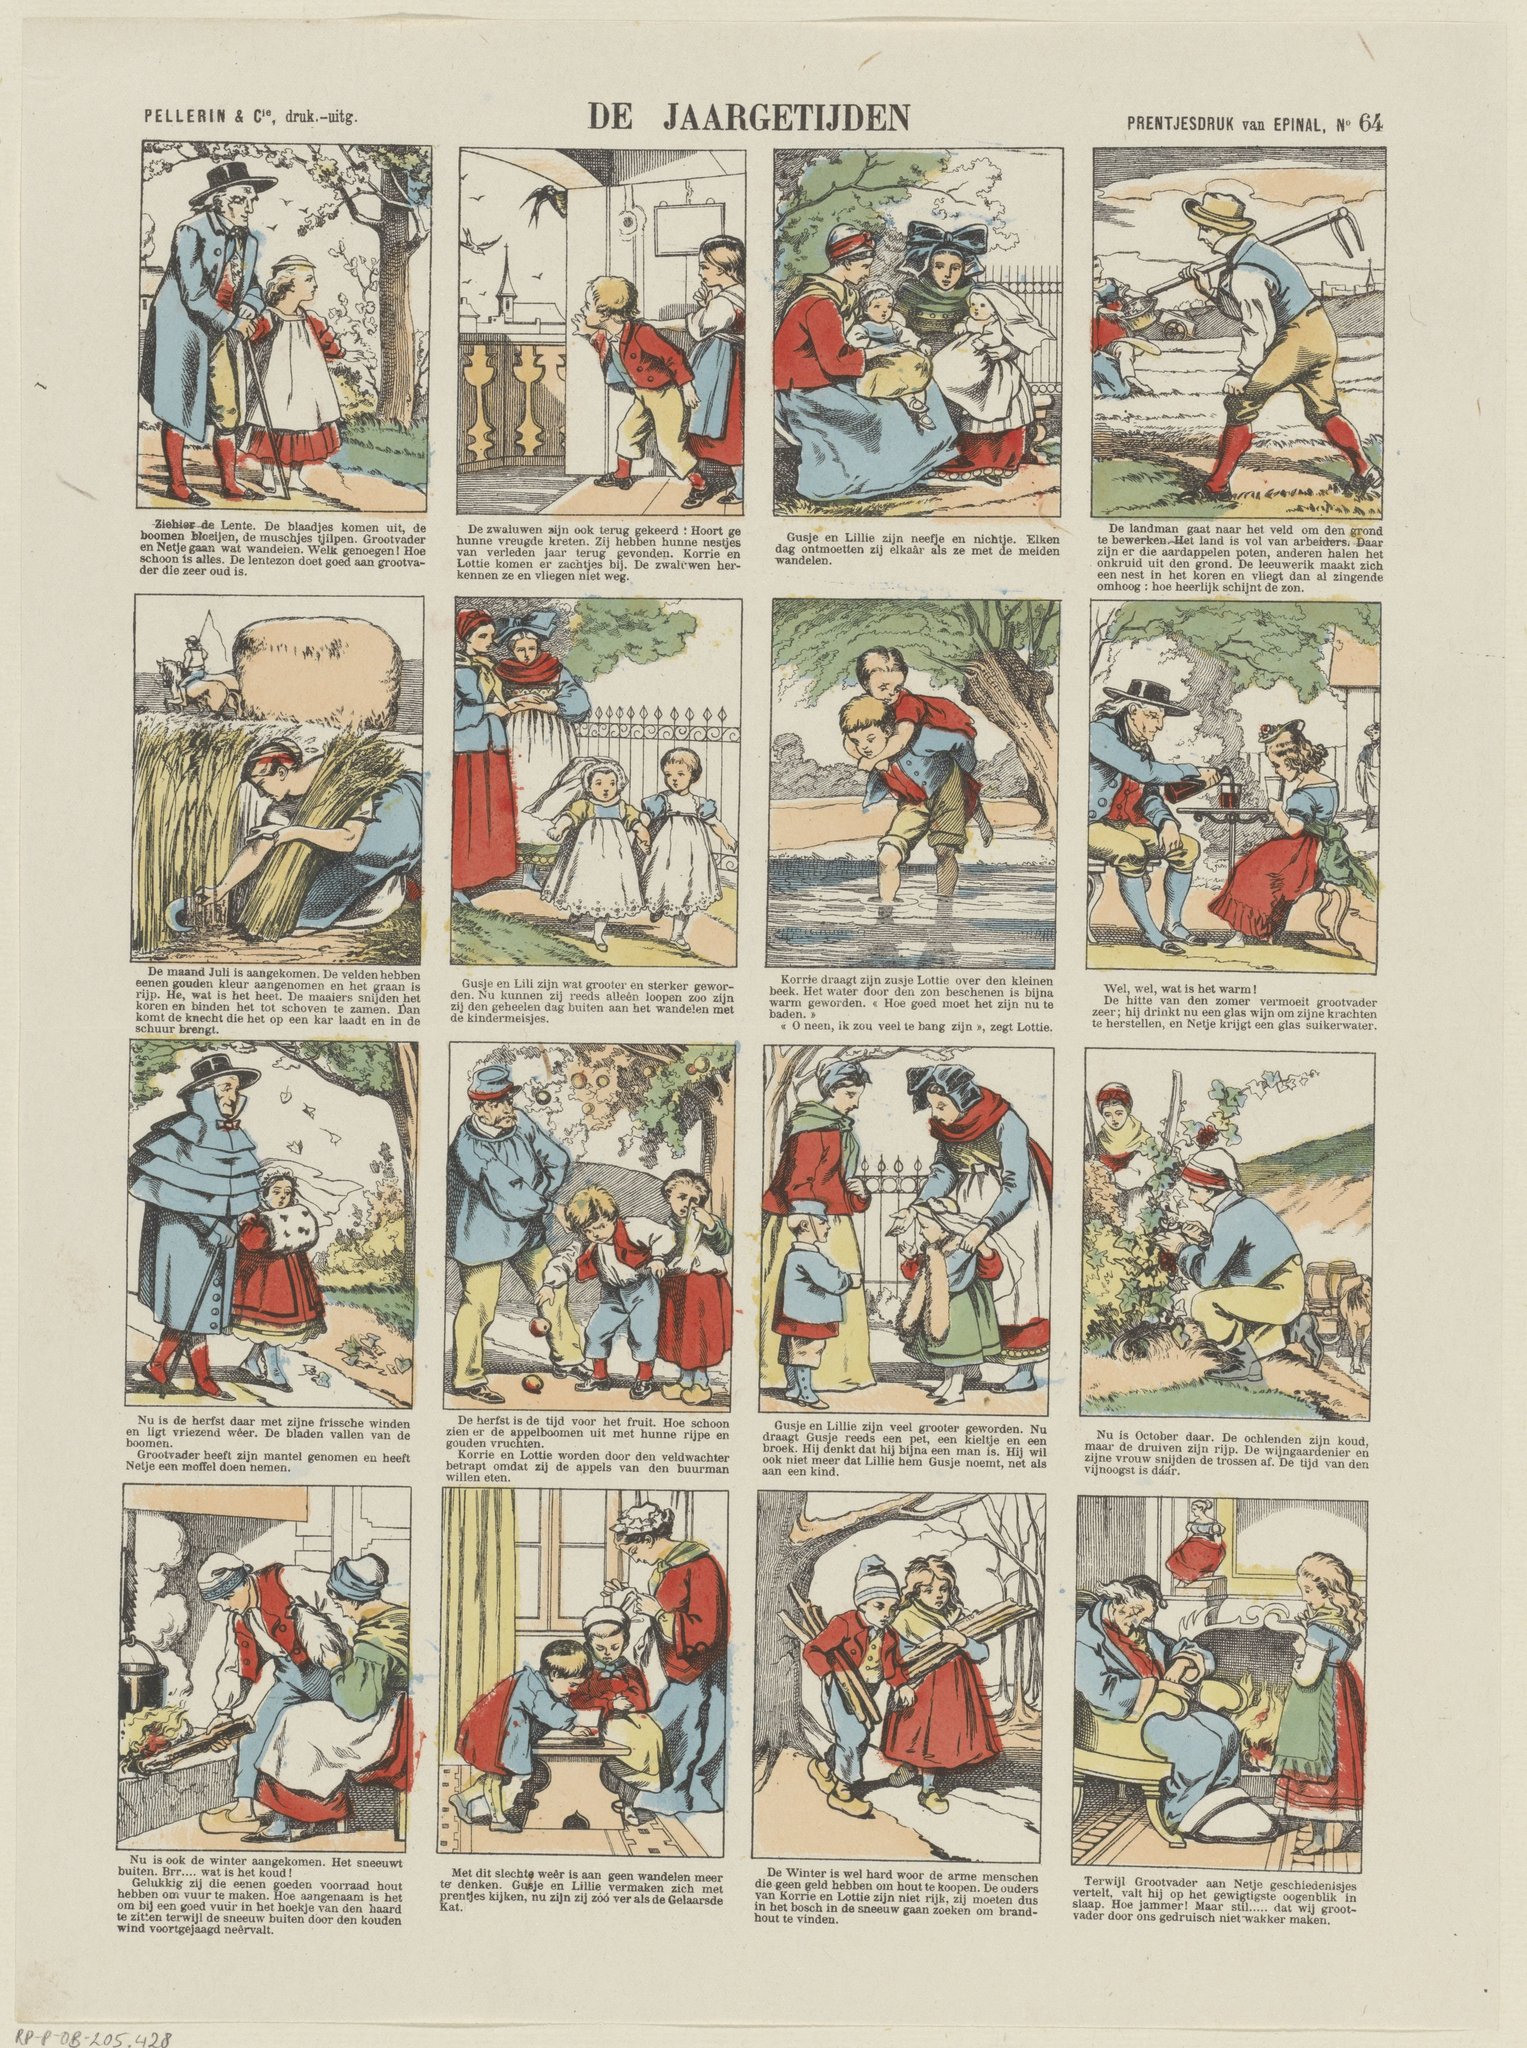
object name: print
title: Prentjesdruk van Épinal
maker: Anonymous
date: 1902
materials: paper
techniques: colour, letterpress printing, lithograph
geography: epinal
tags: the four seasons of the year ~ human activities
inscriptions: collector's mark: Lugt 2760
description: Blad met 16 voorstellingen van de vier jaargetijden en bijbehorende activiteiten. Onder elke afbeelding een onderschrift. Genummerd rechtsboven: No 64.